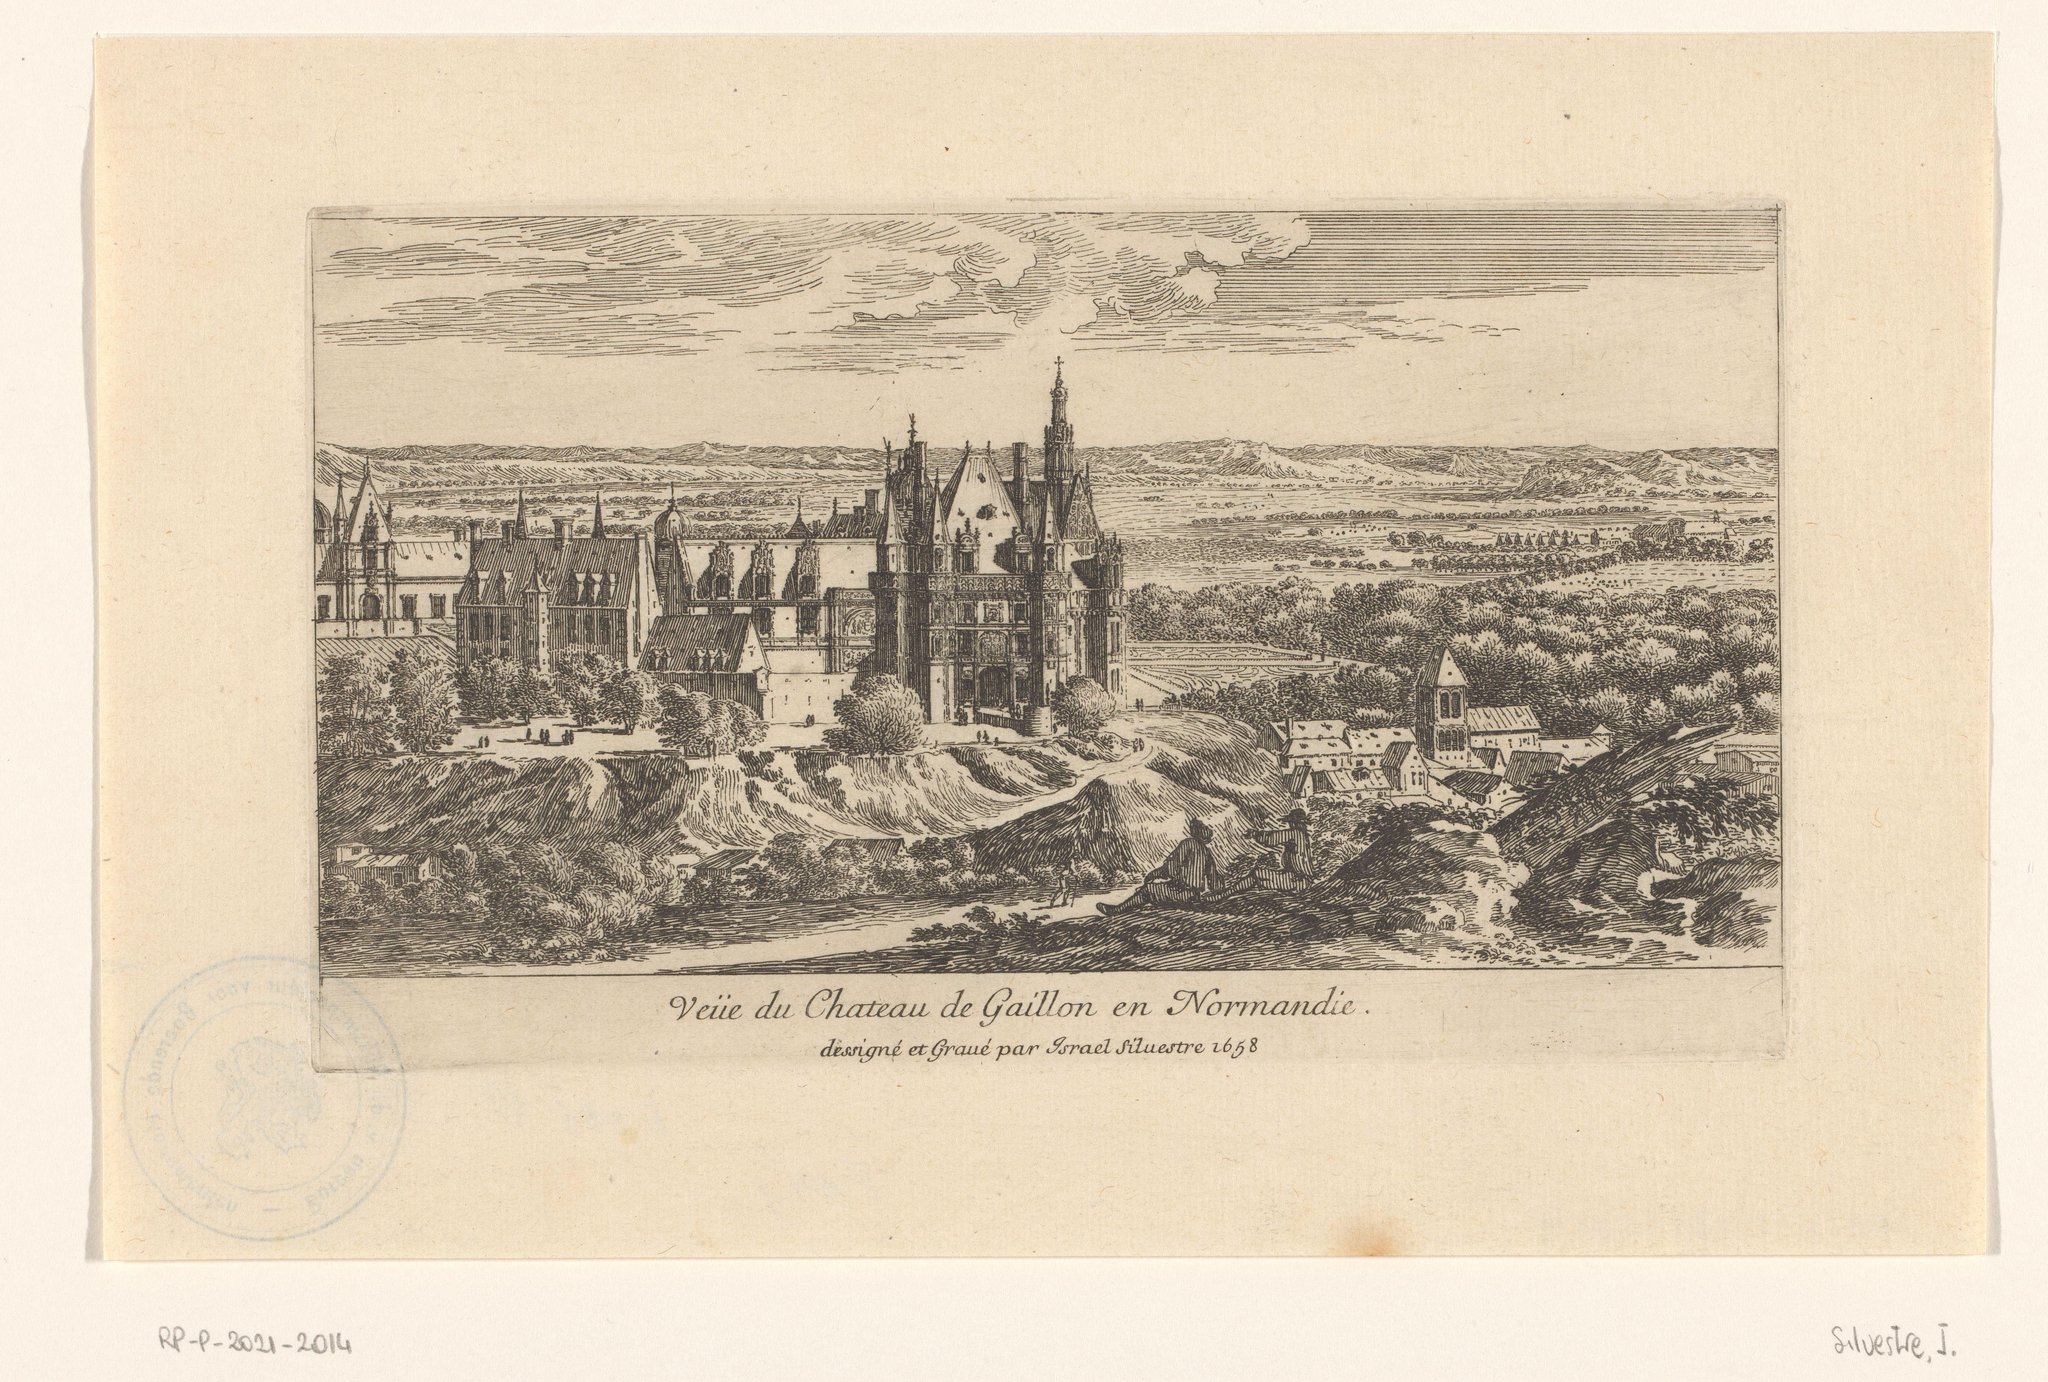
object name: print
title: Diverses Veües faites sur le Naturel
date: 1658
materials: paper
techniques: etching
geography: france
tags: landscape with tower or castle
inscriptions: stamp: ‘Bureau v.d. Rijksinspecteur voor Roerende Monumenten ’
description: Prent maakt deel uit van een ongenummerde serie van tien prenten.